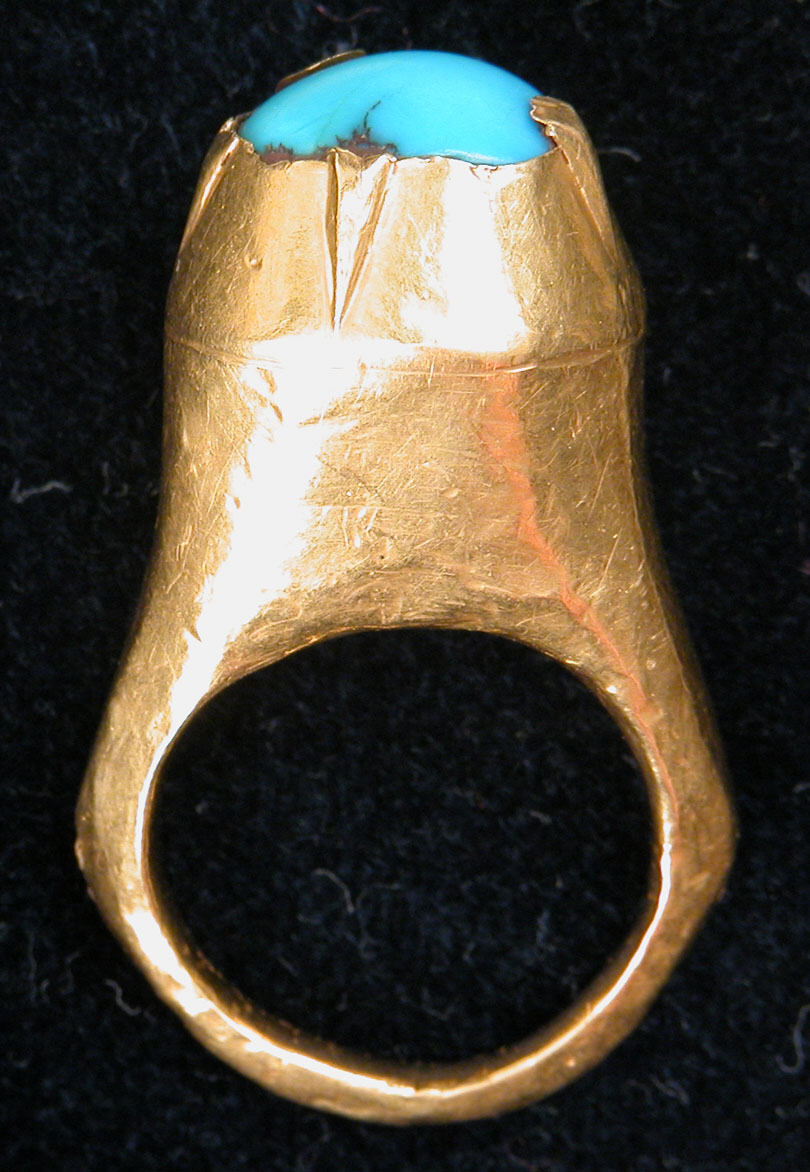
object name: ring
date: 1001-1200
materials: gold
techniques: chasing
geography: iran